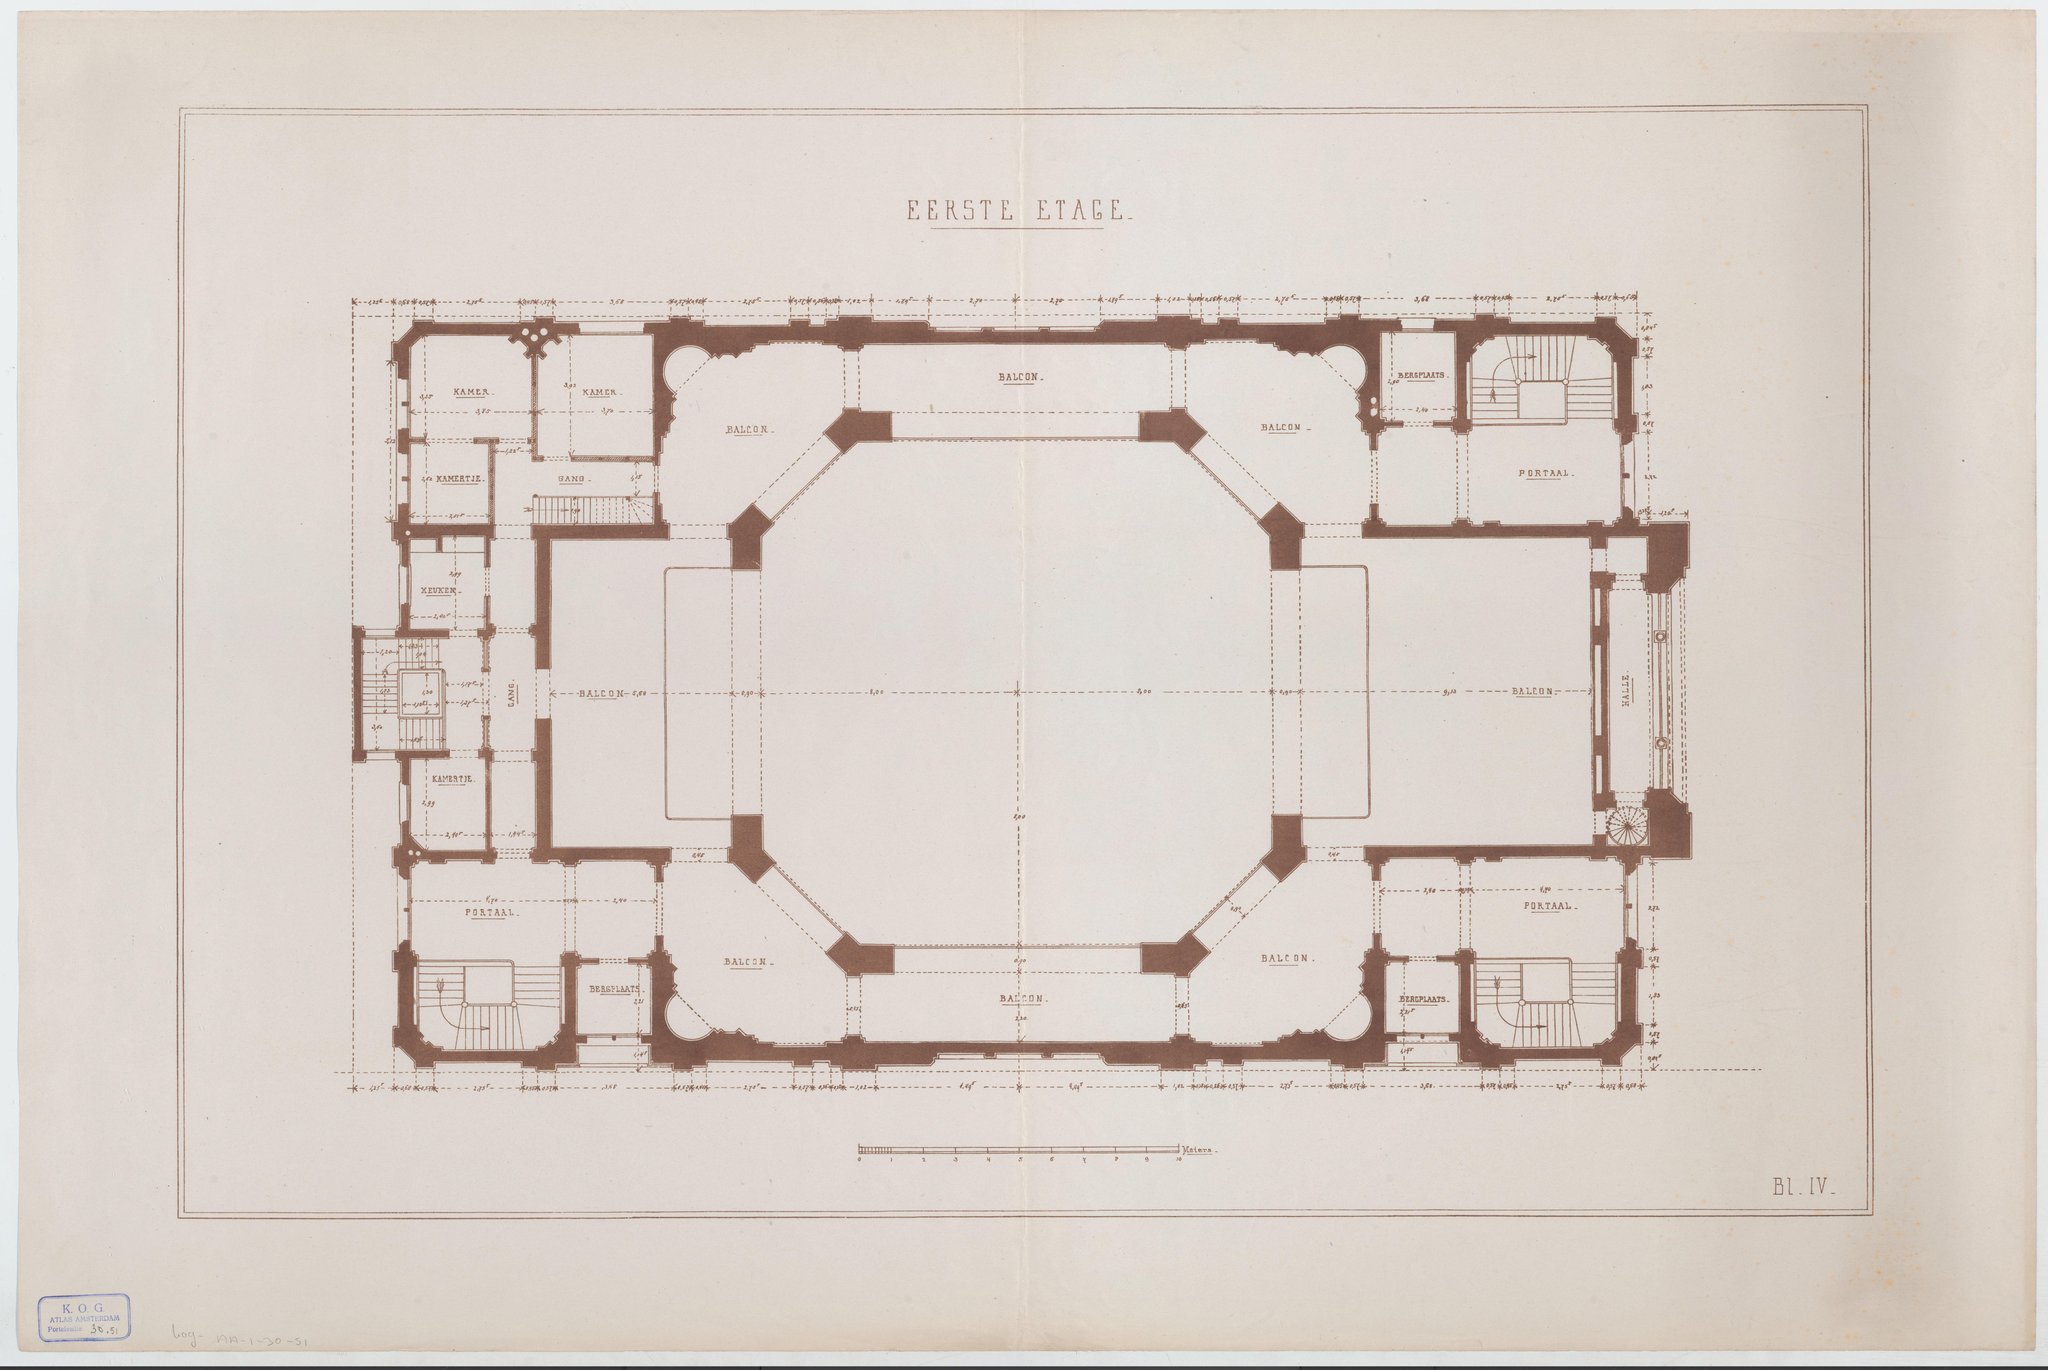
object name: area plan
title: Plattegrond van de eerste verdieping van de Koepelkerk te Amsterdam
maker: Anonymous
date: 1881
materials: paper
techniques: lithograph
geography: amsterdam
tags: floor plan ~ architectural design or model, building of church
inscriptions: collector's mark: Lugt 1641b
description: Rechtsonder: Bl. IV. Onderwerpsrubriek binnen de Atlas Amsterdam: Kerkwezen: Hervormde Gemeente: Koepelkerk (Leidsebosje).